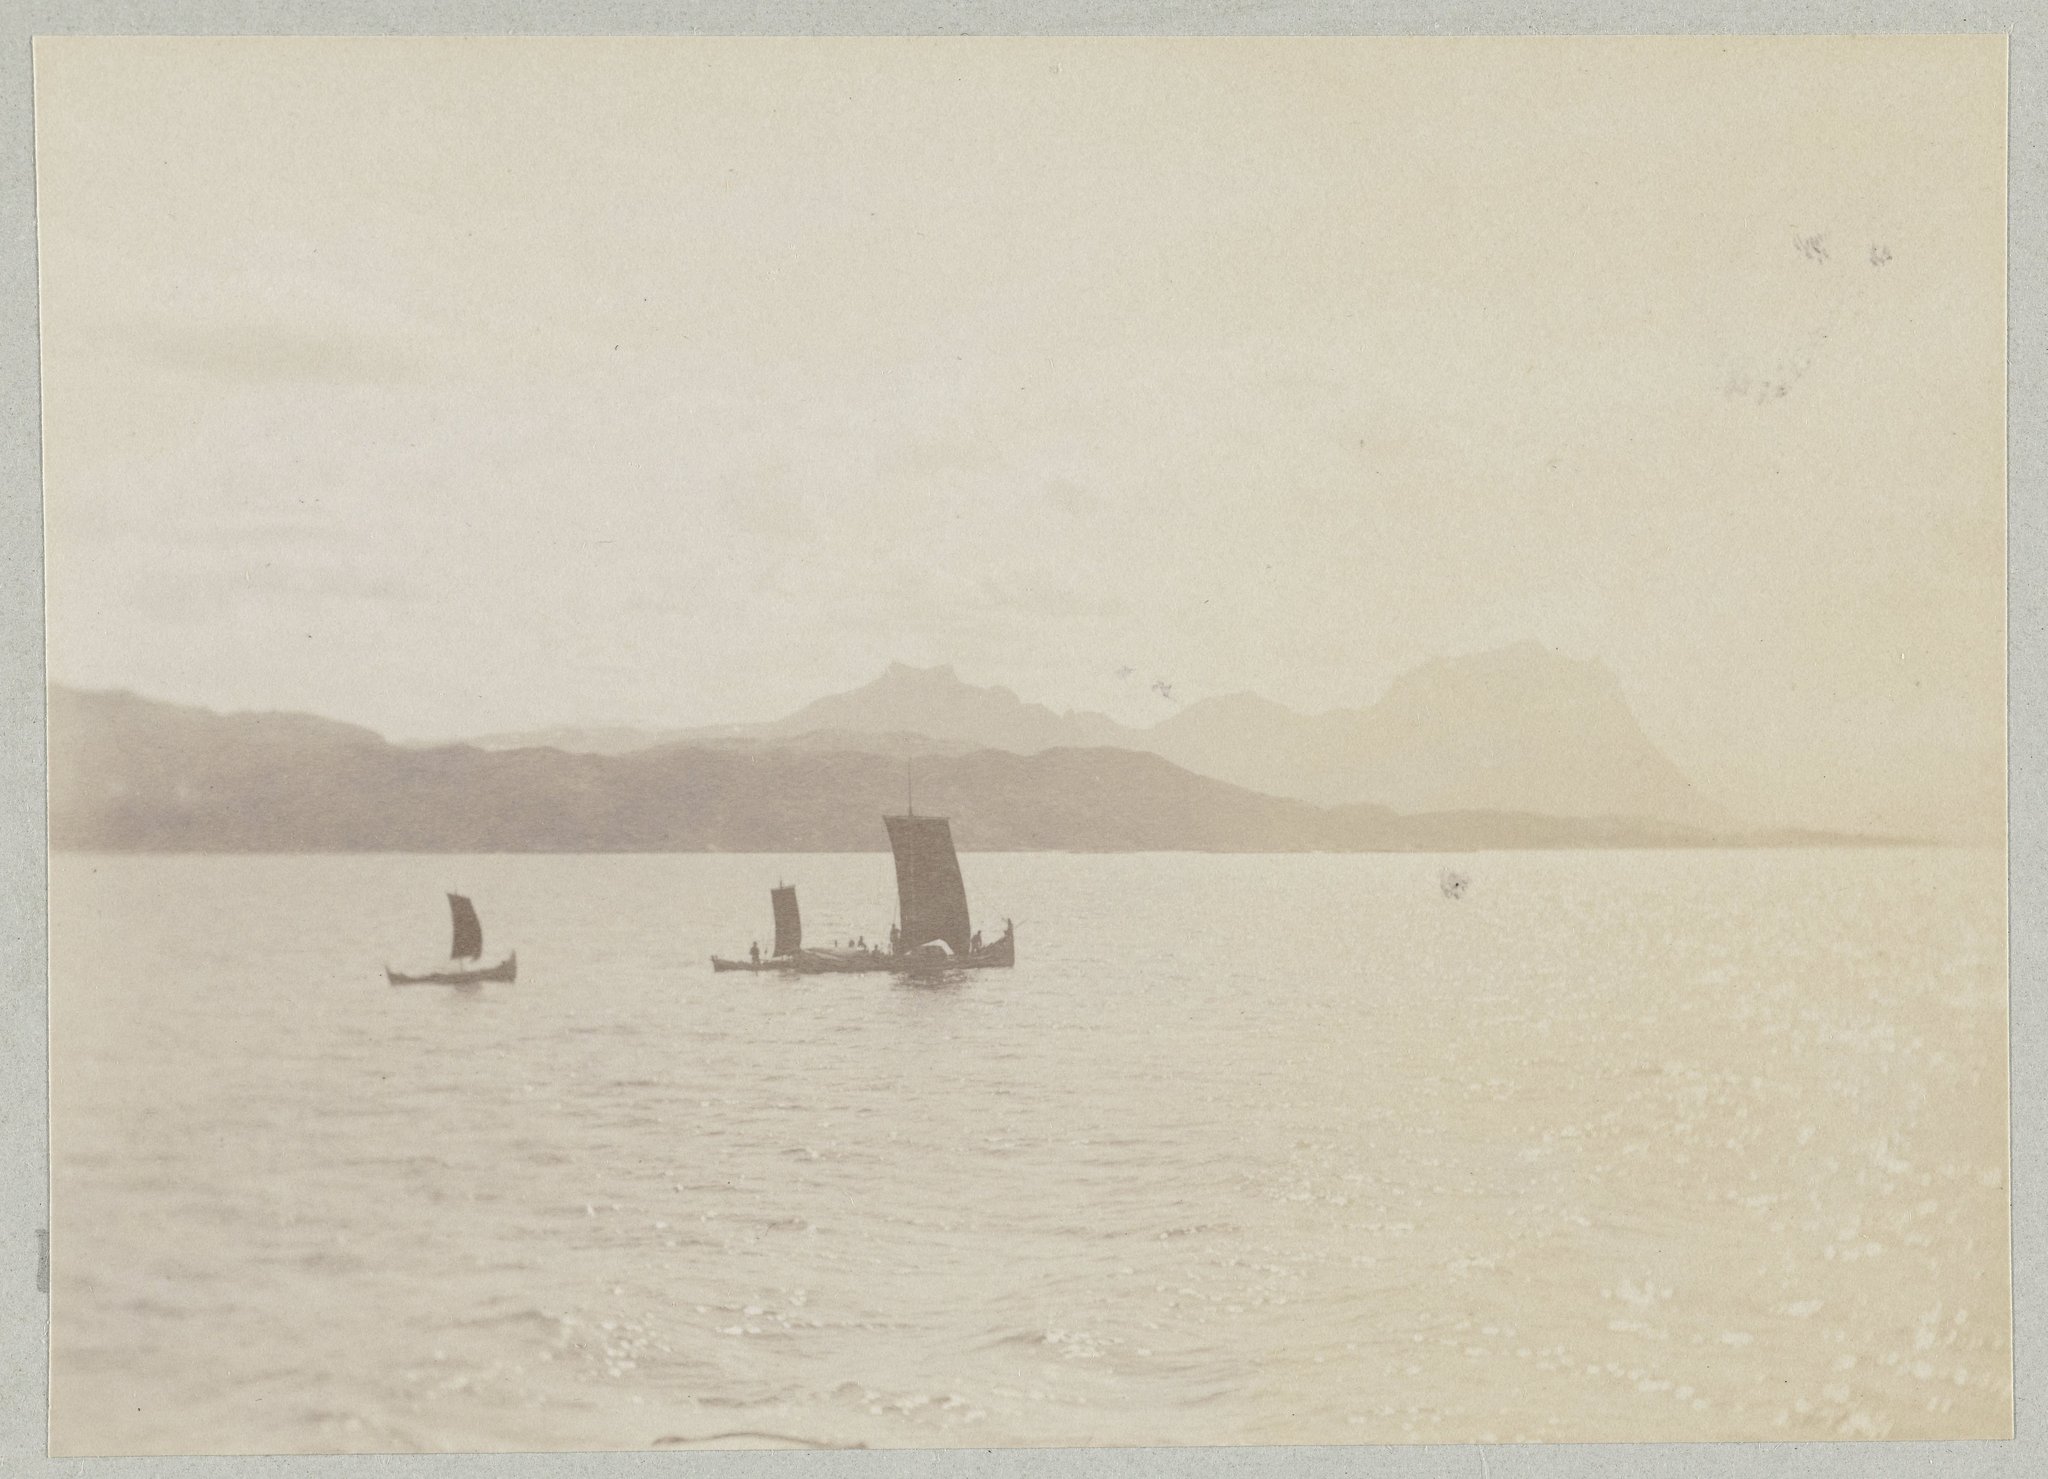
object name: photograph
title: Auf der fahrt nach Bodö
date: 1807-1889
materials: cardboard, paper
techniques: albumen print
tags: wilhelm ii (keizer van duitsland), norway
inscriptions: number: ‘23’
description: De afdruk van de foto is rond, het papier vierkant